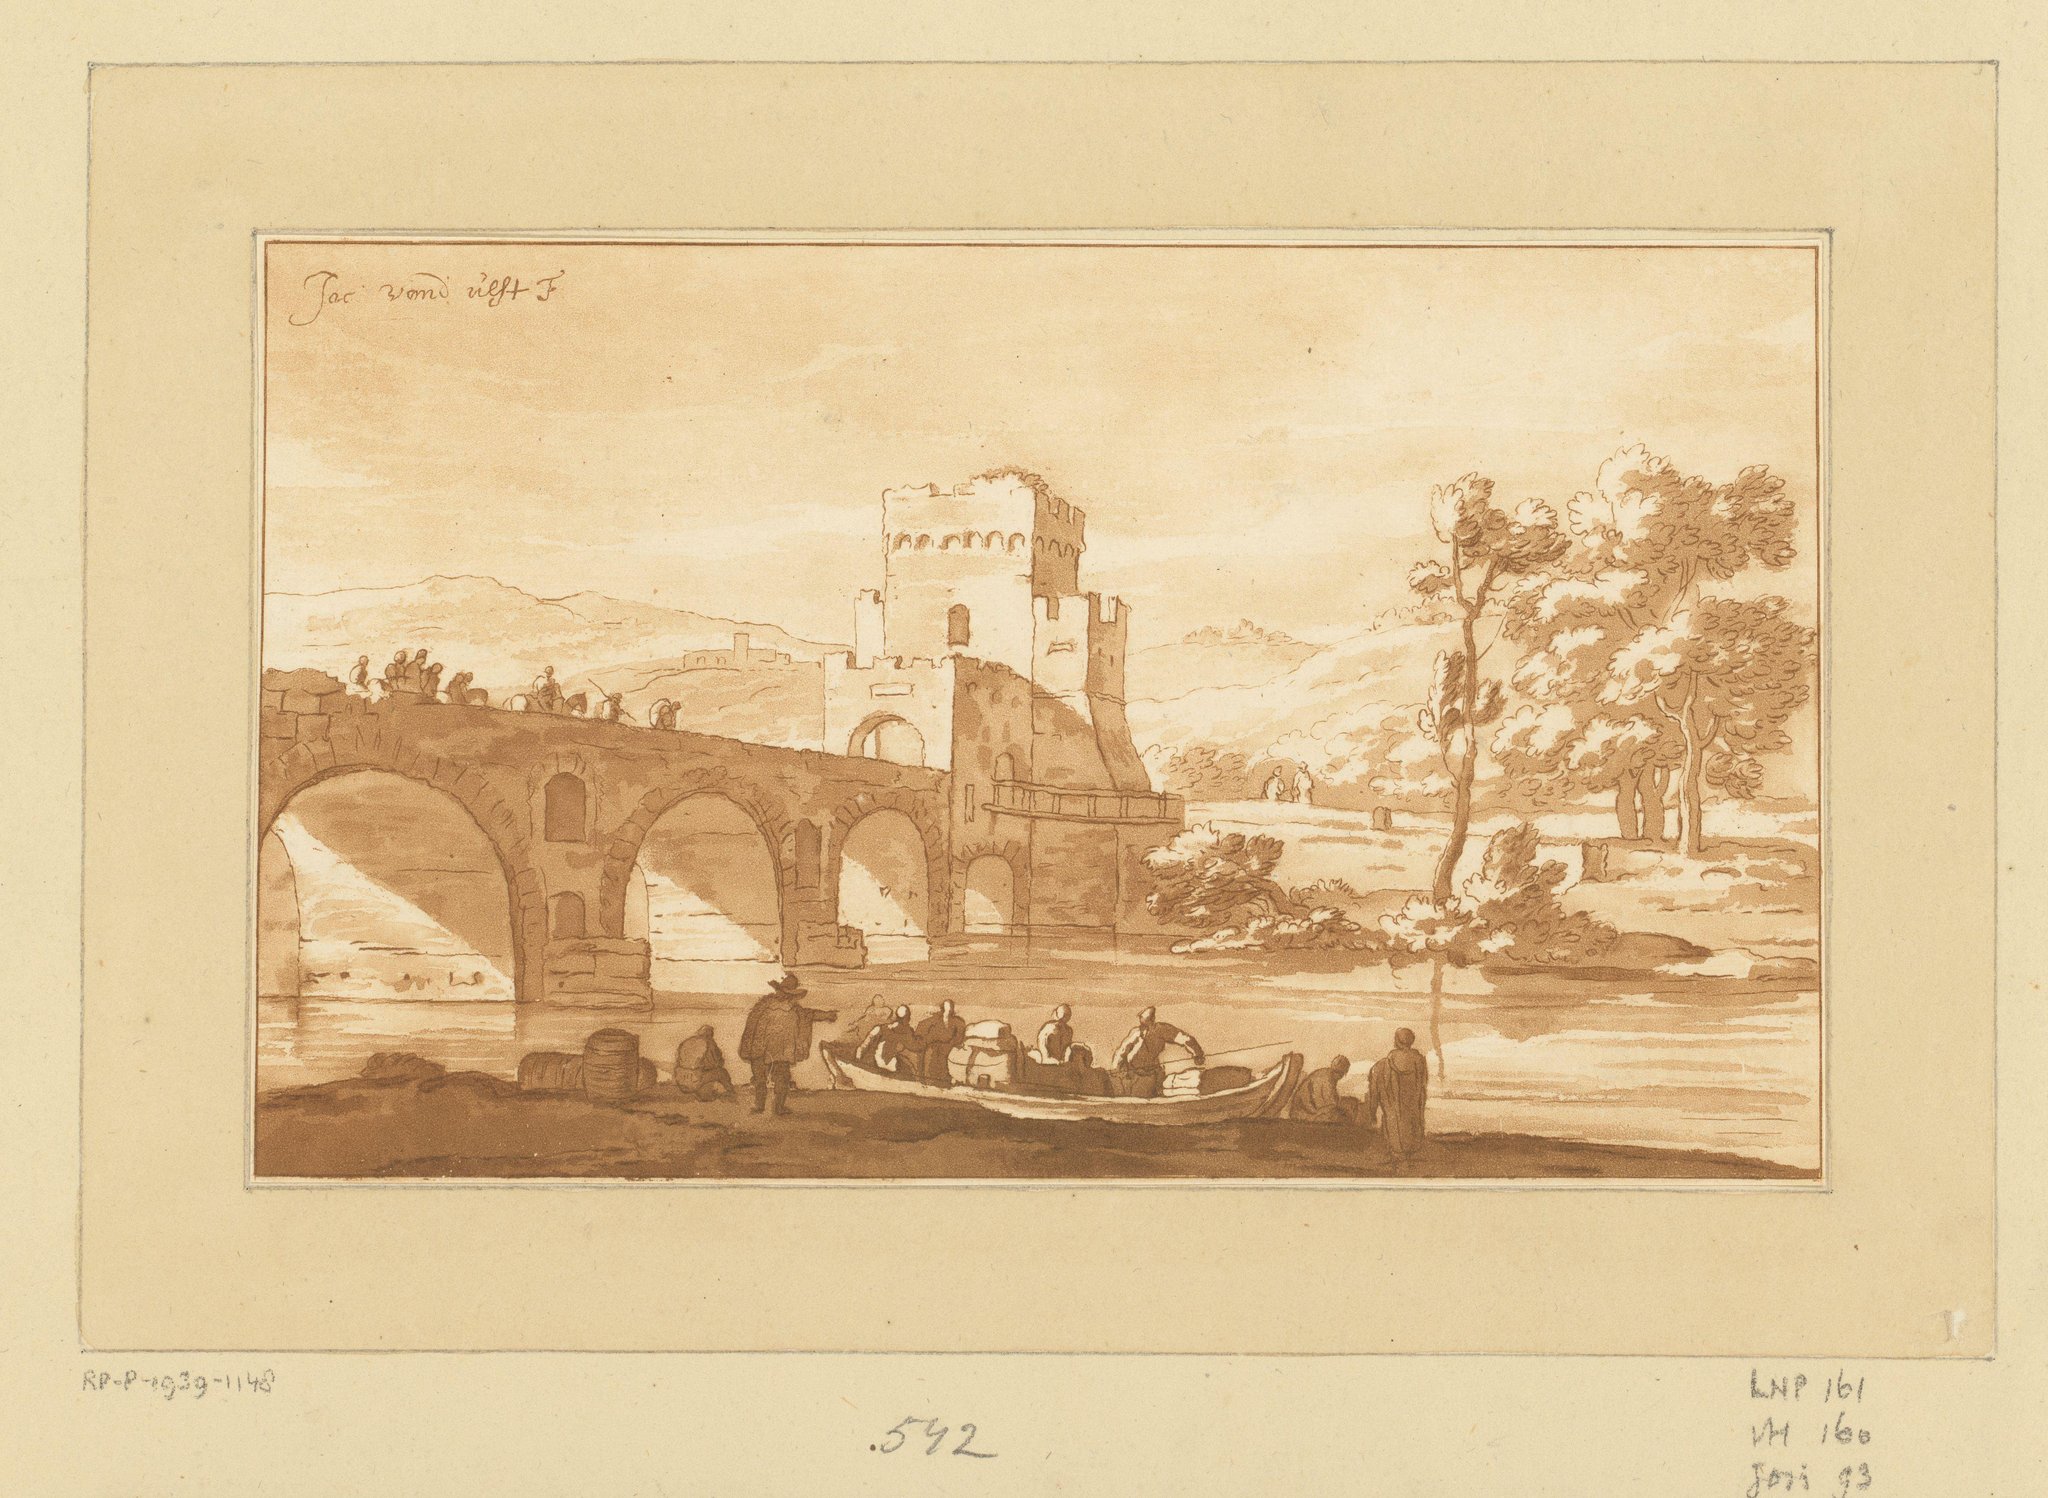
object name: print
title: Ponte Molle bij Rome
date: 1741-1803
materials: paper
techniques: etching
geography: amsterdam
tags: landscape with bridge, viaduct or aqueduct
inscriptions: collector's mark: ‘RIJKS / MUSM’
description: Cornelis Brouwer heeft in samenwerking met C.S. Roos een aantal prenttekeningen uitgegeven welke op het verso het signatuur C.Brouwer fecit en C.S. Roos excudit Amst. dragen. De prent werd opgenomen in: Collection d'imitations de dessins d'après les principaux maîtres hollandais et flamands, Londen, C. Josi, 1821.